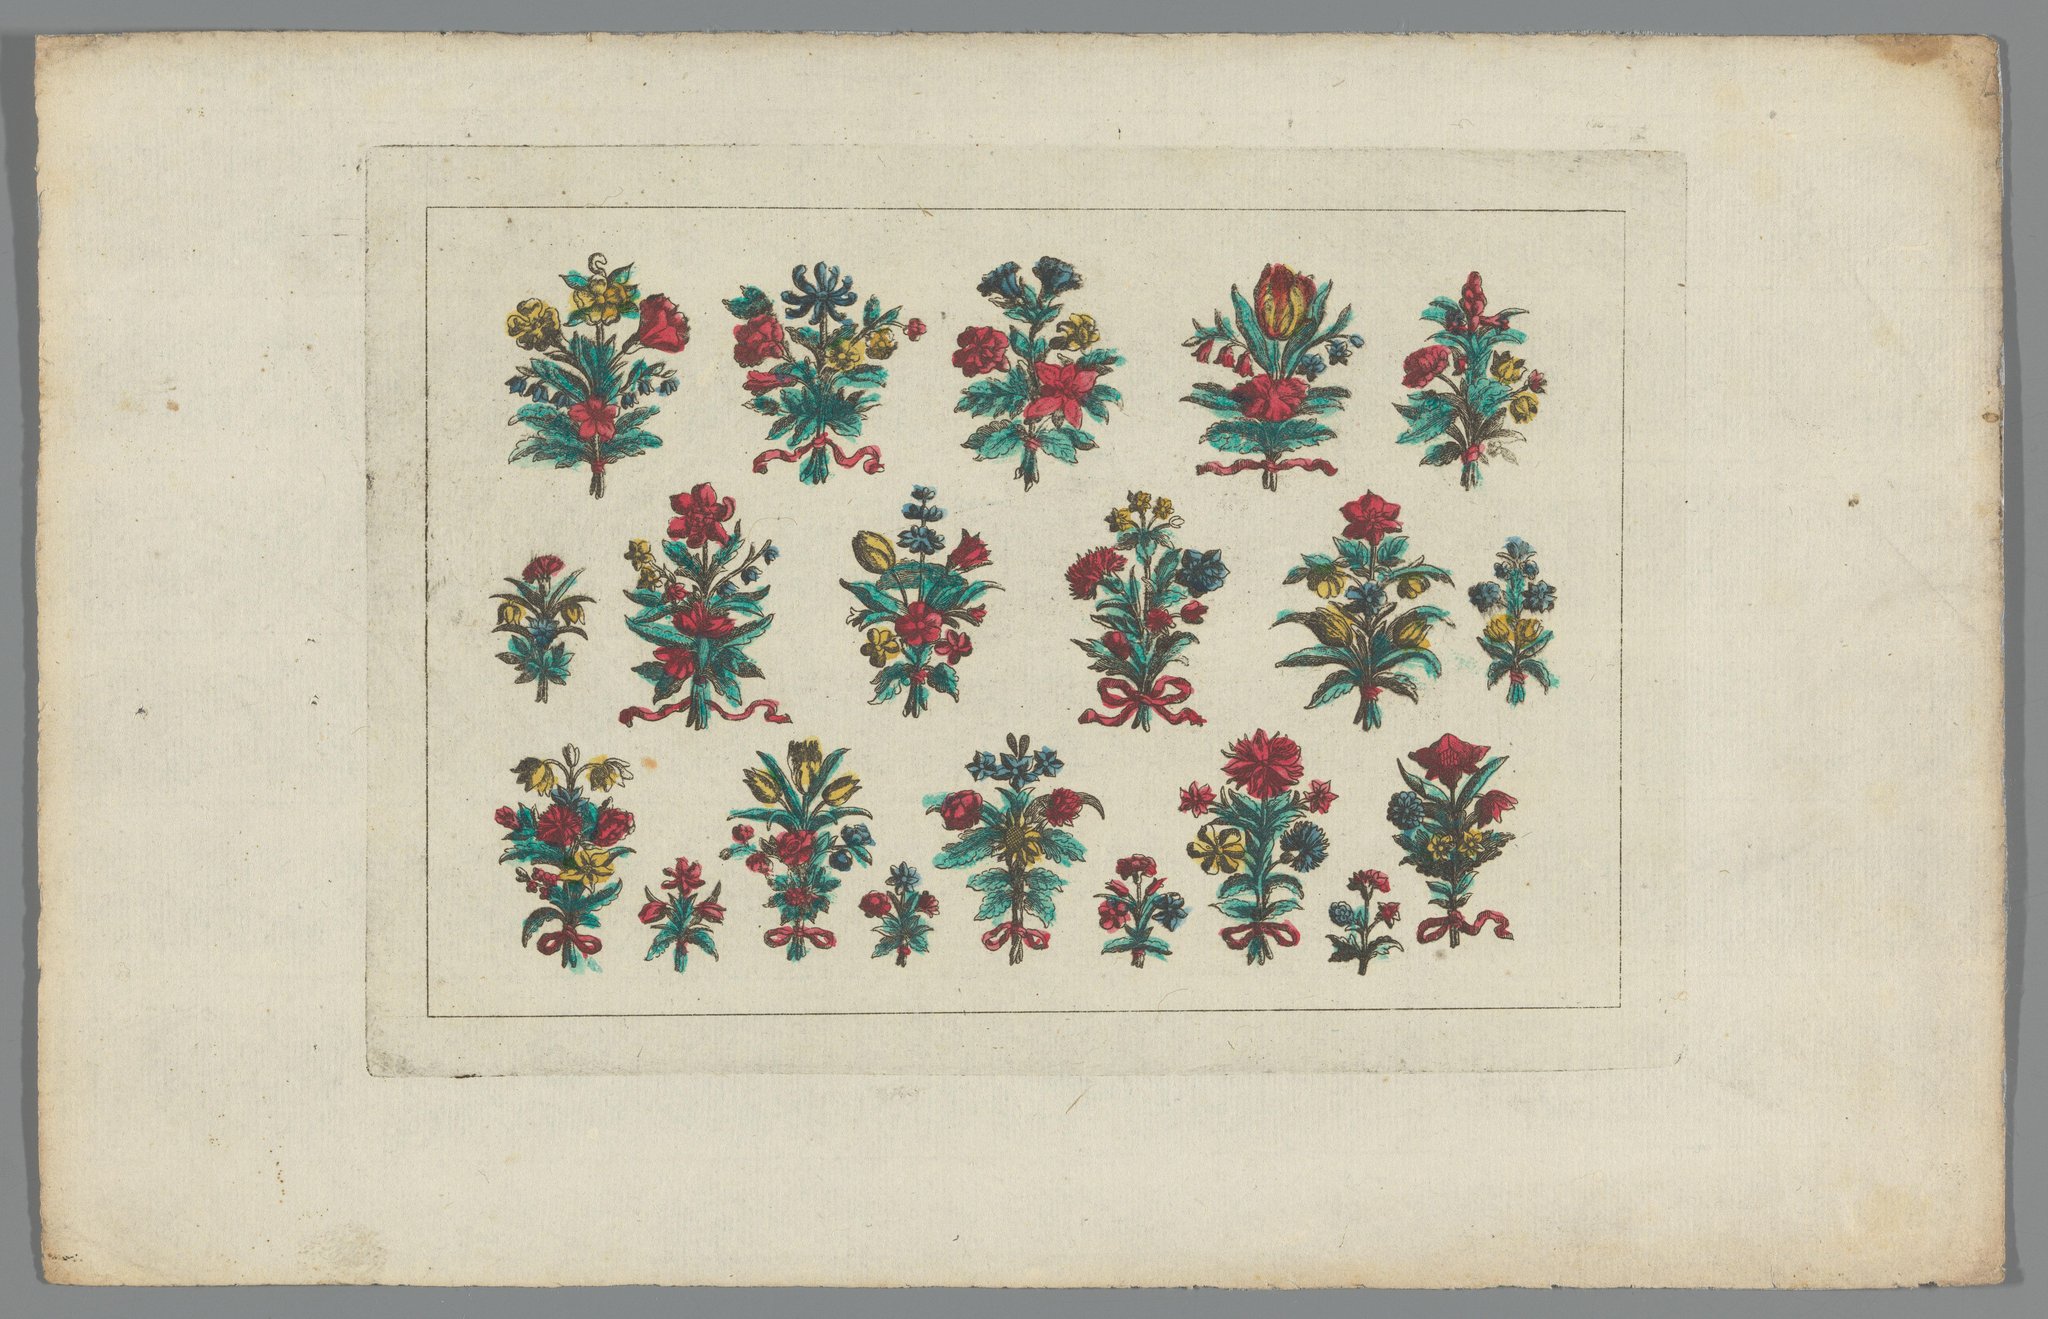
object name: print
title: Bladen met knipplaatjes en decoratieve randen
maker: Anonymous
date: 1750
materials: paper, watercolor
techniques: etching, hand coloring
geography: paris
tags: flowers, cut flowers; nosegay, bunch of flowers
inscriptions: collector's mark: Lugt 2760, collector's mark: Lugt 2228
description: Drie rijen met grote en kleine boeketten, gebonden met een strik. Een van 39 bladen met knipplaatjes en decoratieve randen.